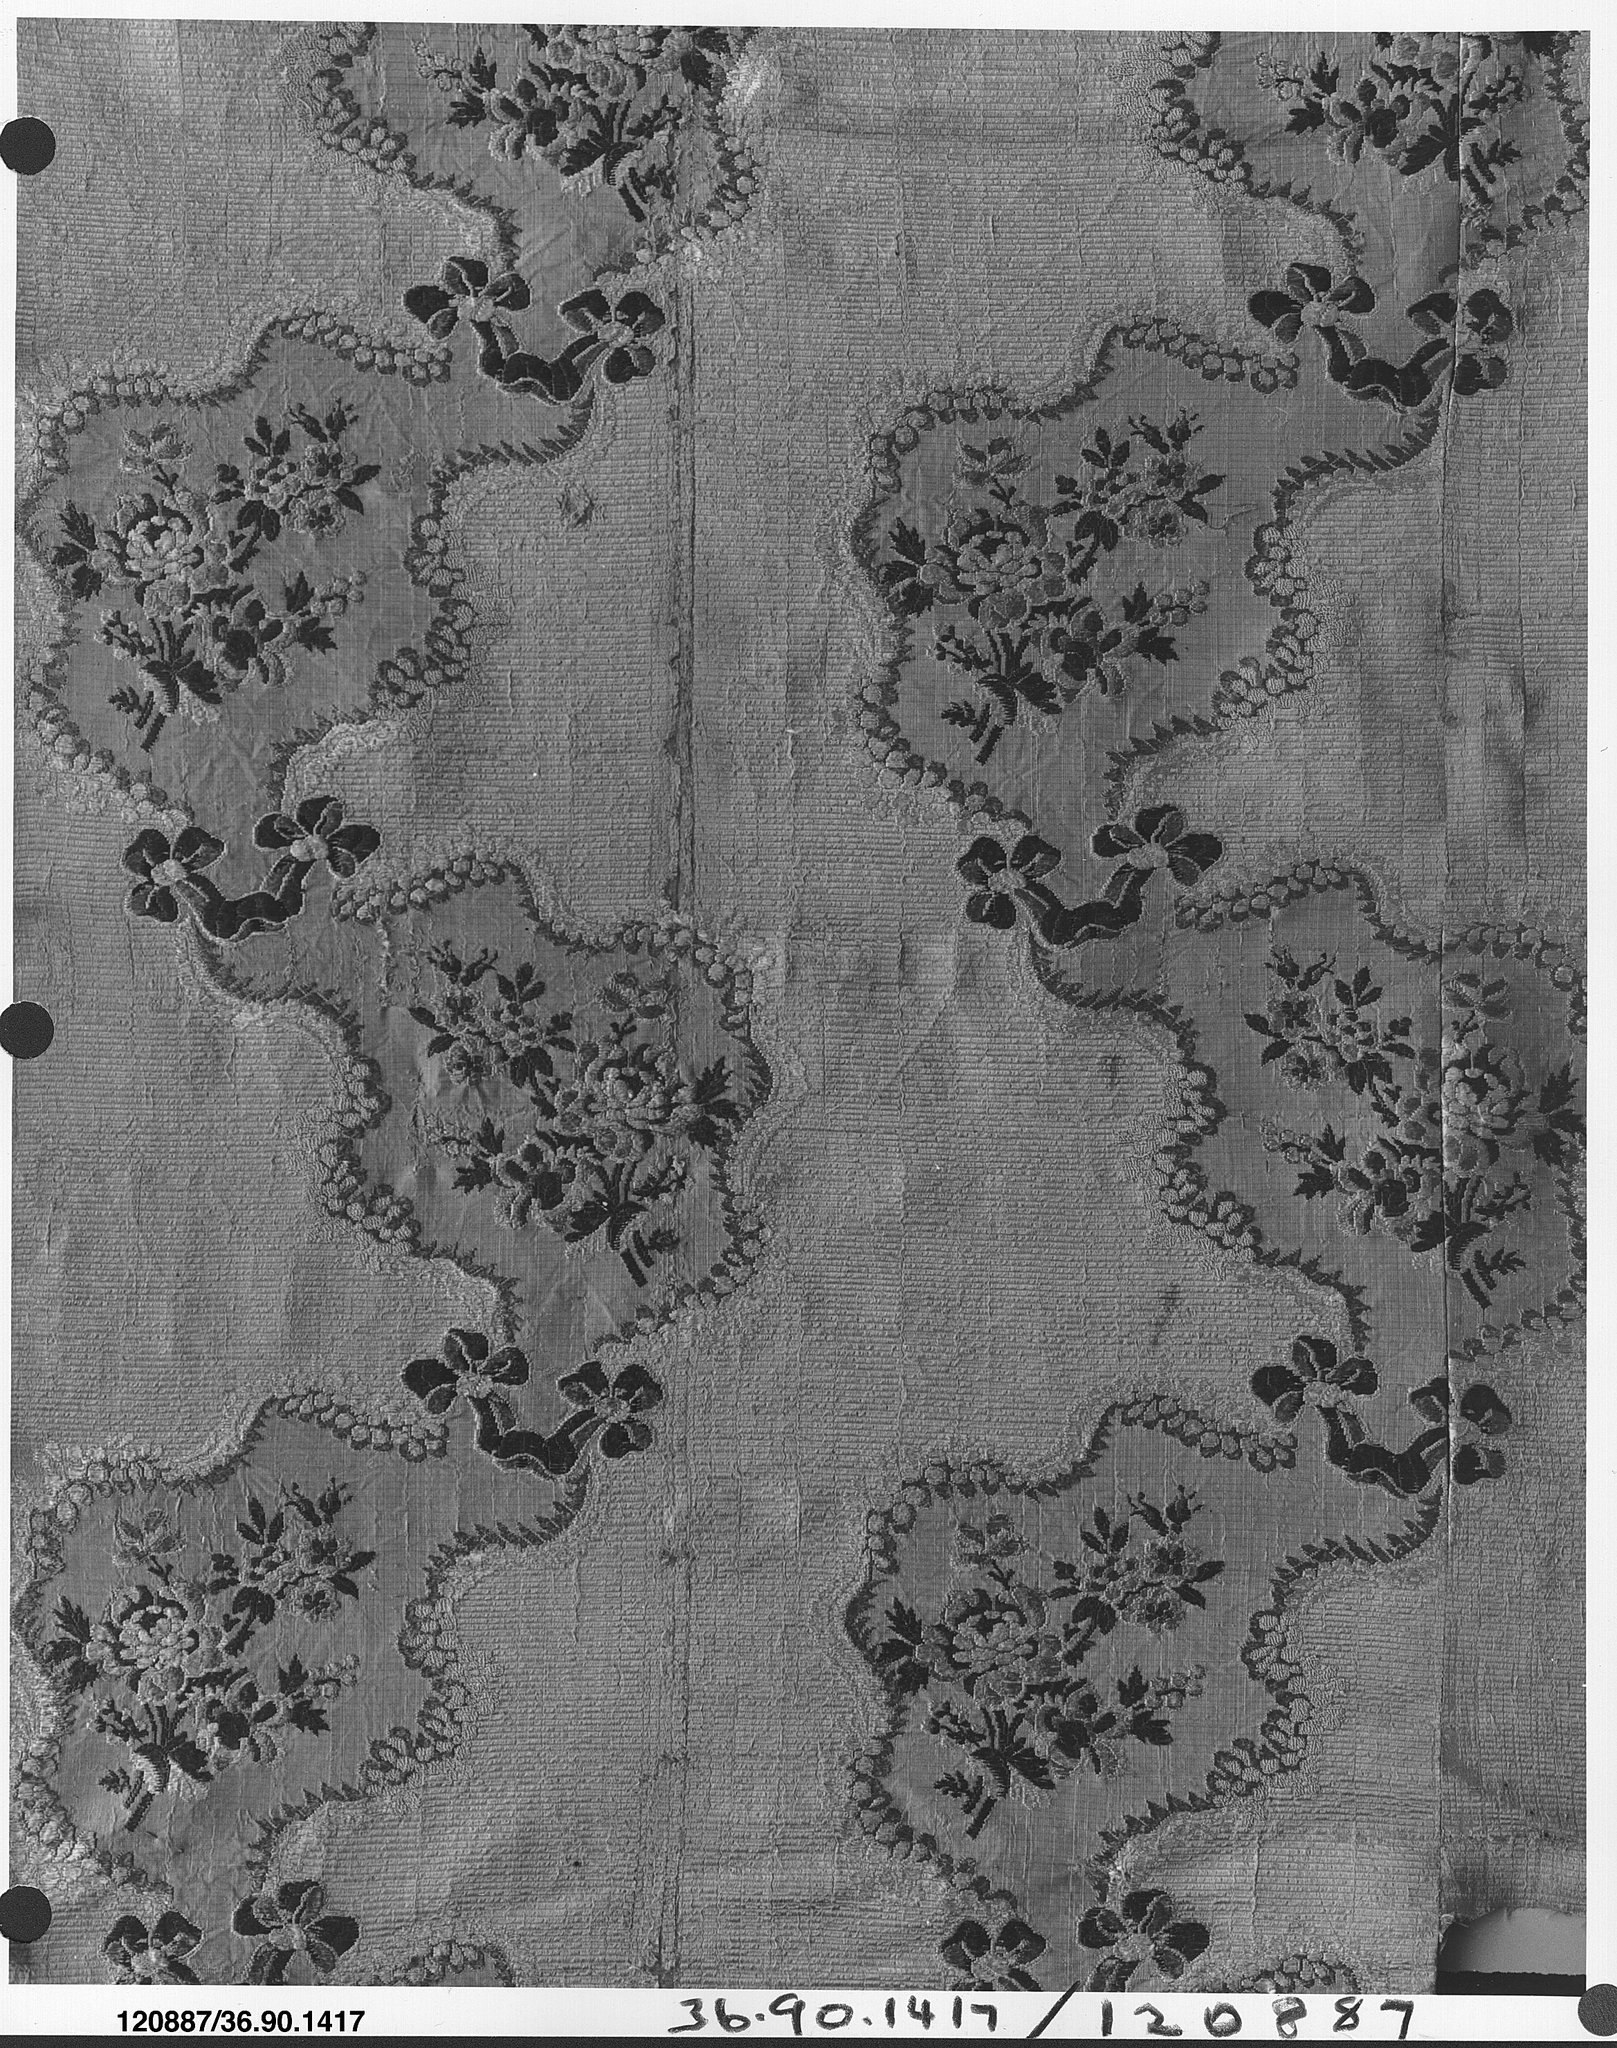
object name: piece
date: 1760-1770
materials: silk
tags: flowers,leaves